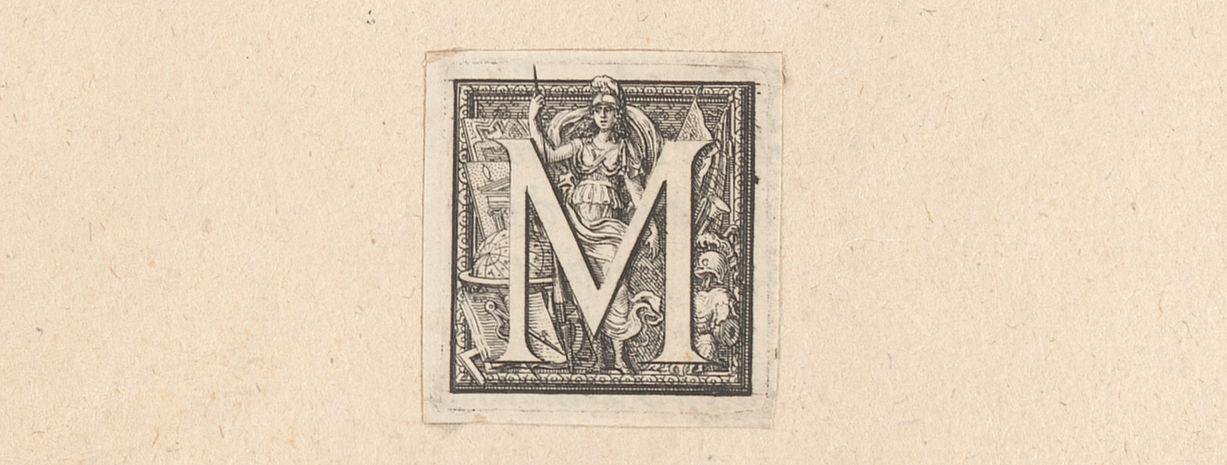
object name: album leaf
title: Initiaal 'M' met Minerva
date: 1687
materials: paper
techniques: etching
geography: paris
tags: (story of) minerva (pallas, athena), initial